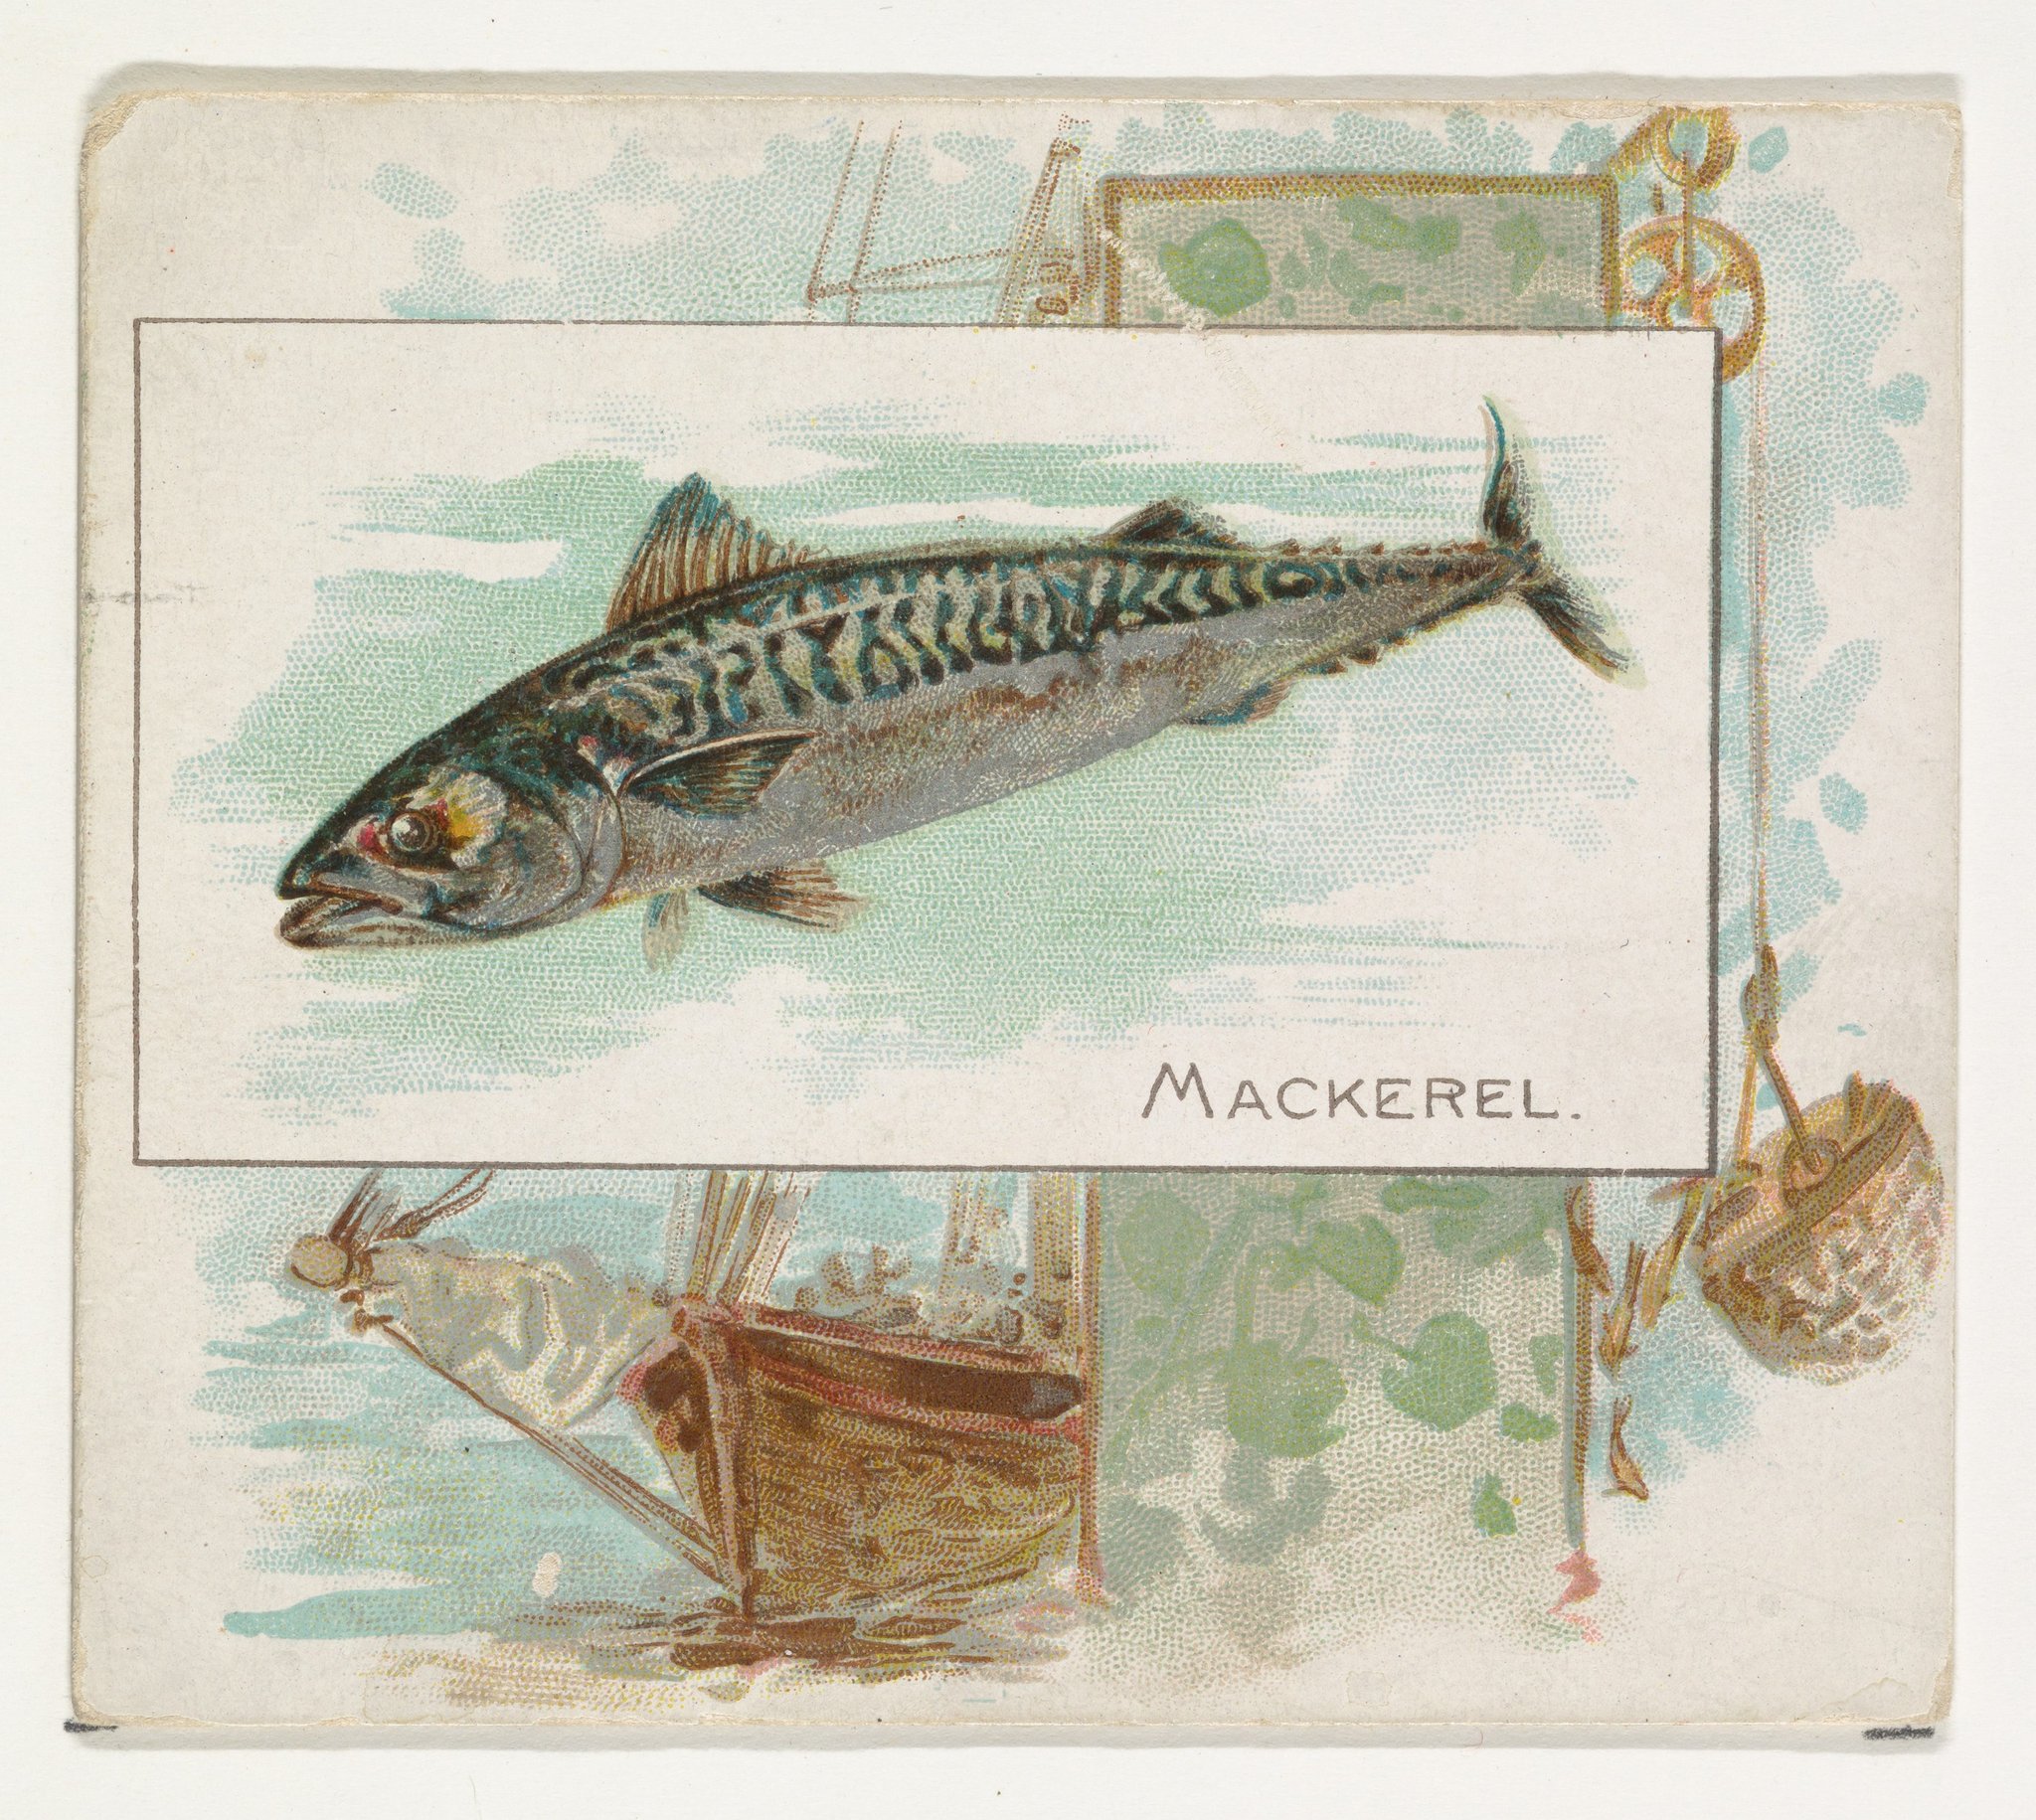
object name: print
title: Mackerel, from Fish from American Waters series (N39) for Allen & Ginter Cigarettes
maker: allen & ginter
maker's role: publisher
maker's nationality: american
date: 1889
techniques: color lithograph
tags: fish